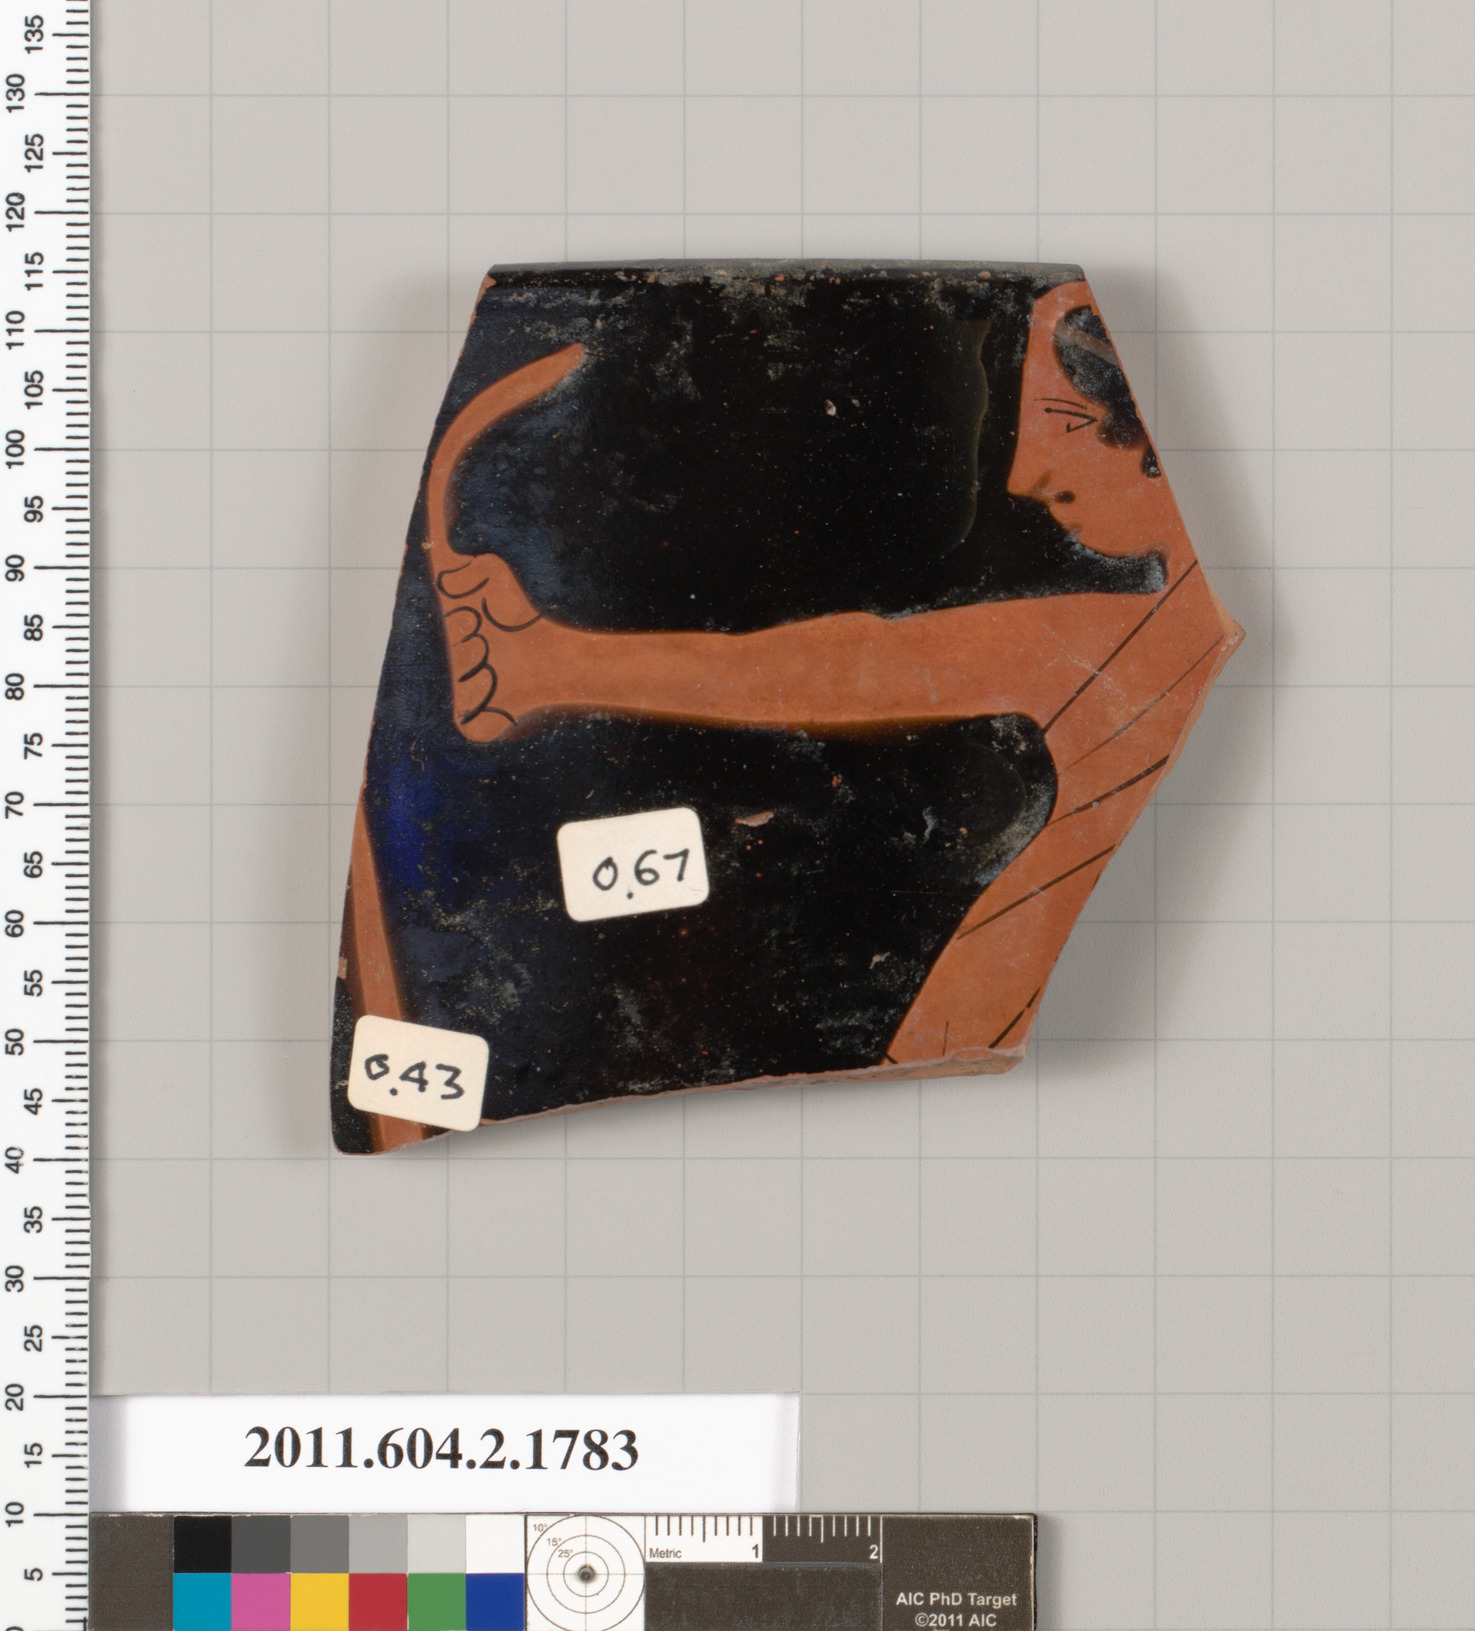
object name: skyphos fragment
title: Terracotta rim fragment of a skyphos (deep drinking cup)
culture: greek, attic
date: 400-376 BCE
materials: terracotta